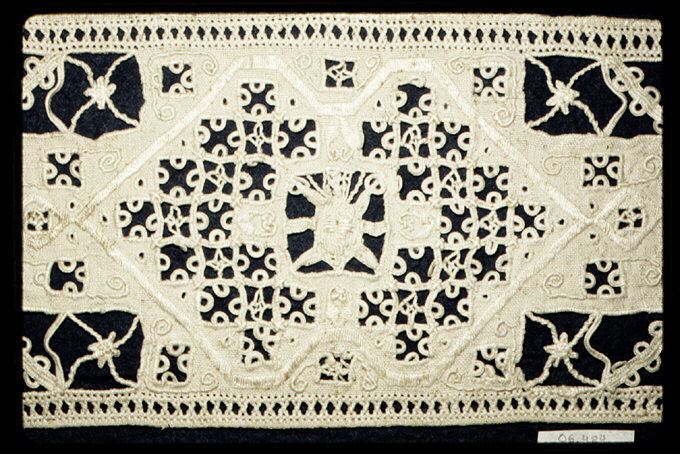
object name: strip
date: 1551-1600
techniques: embroidery